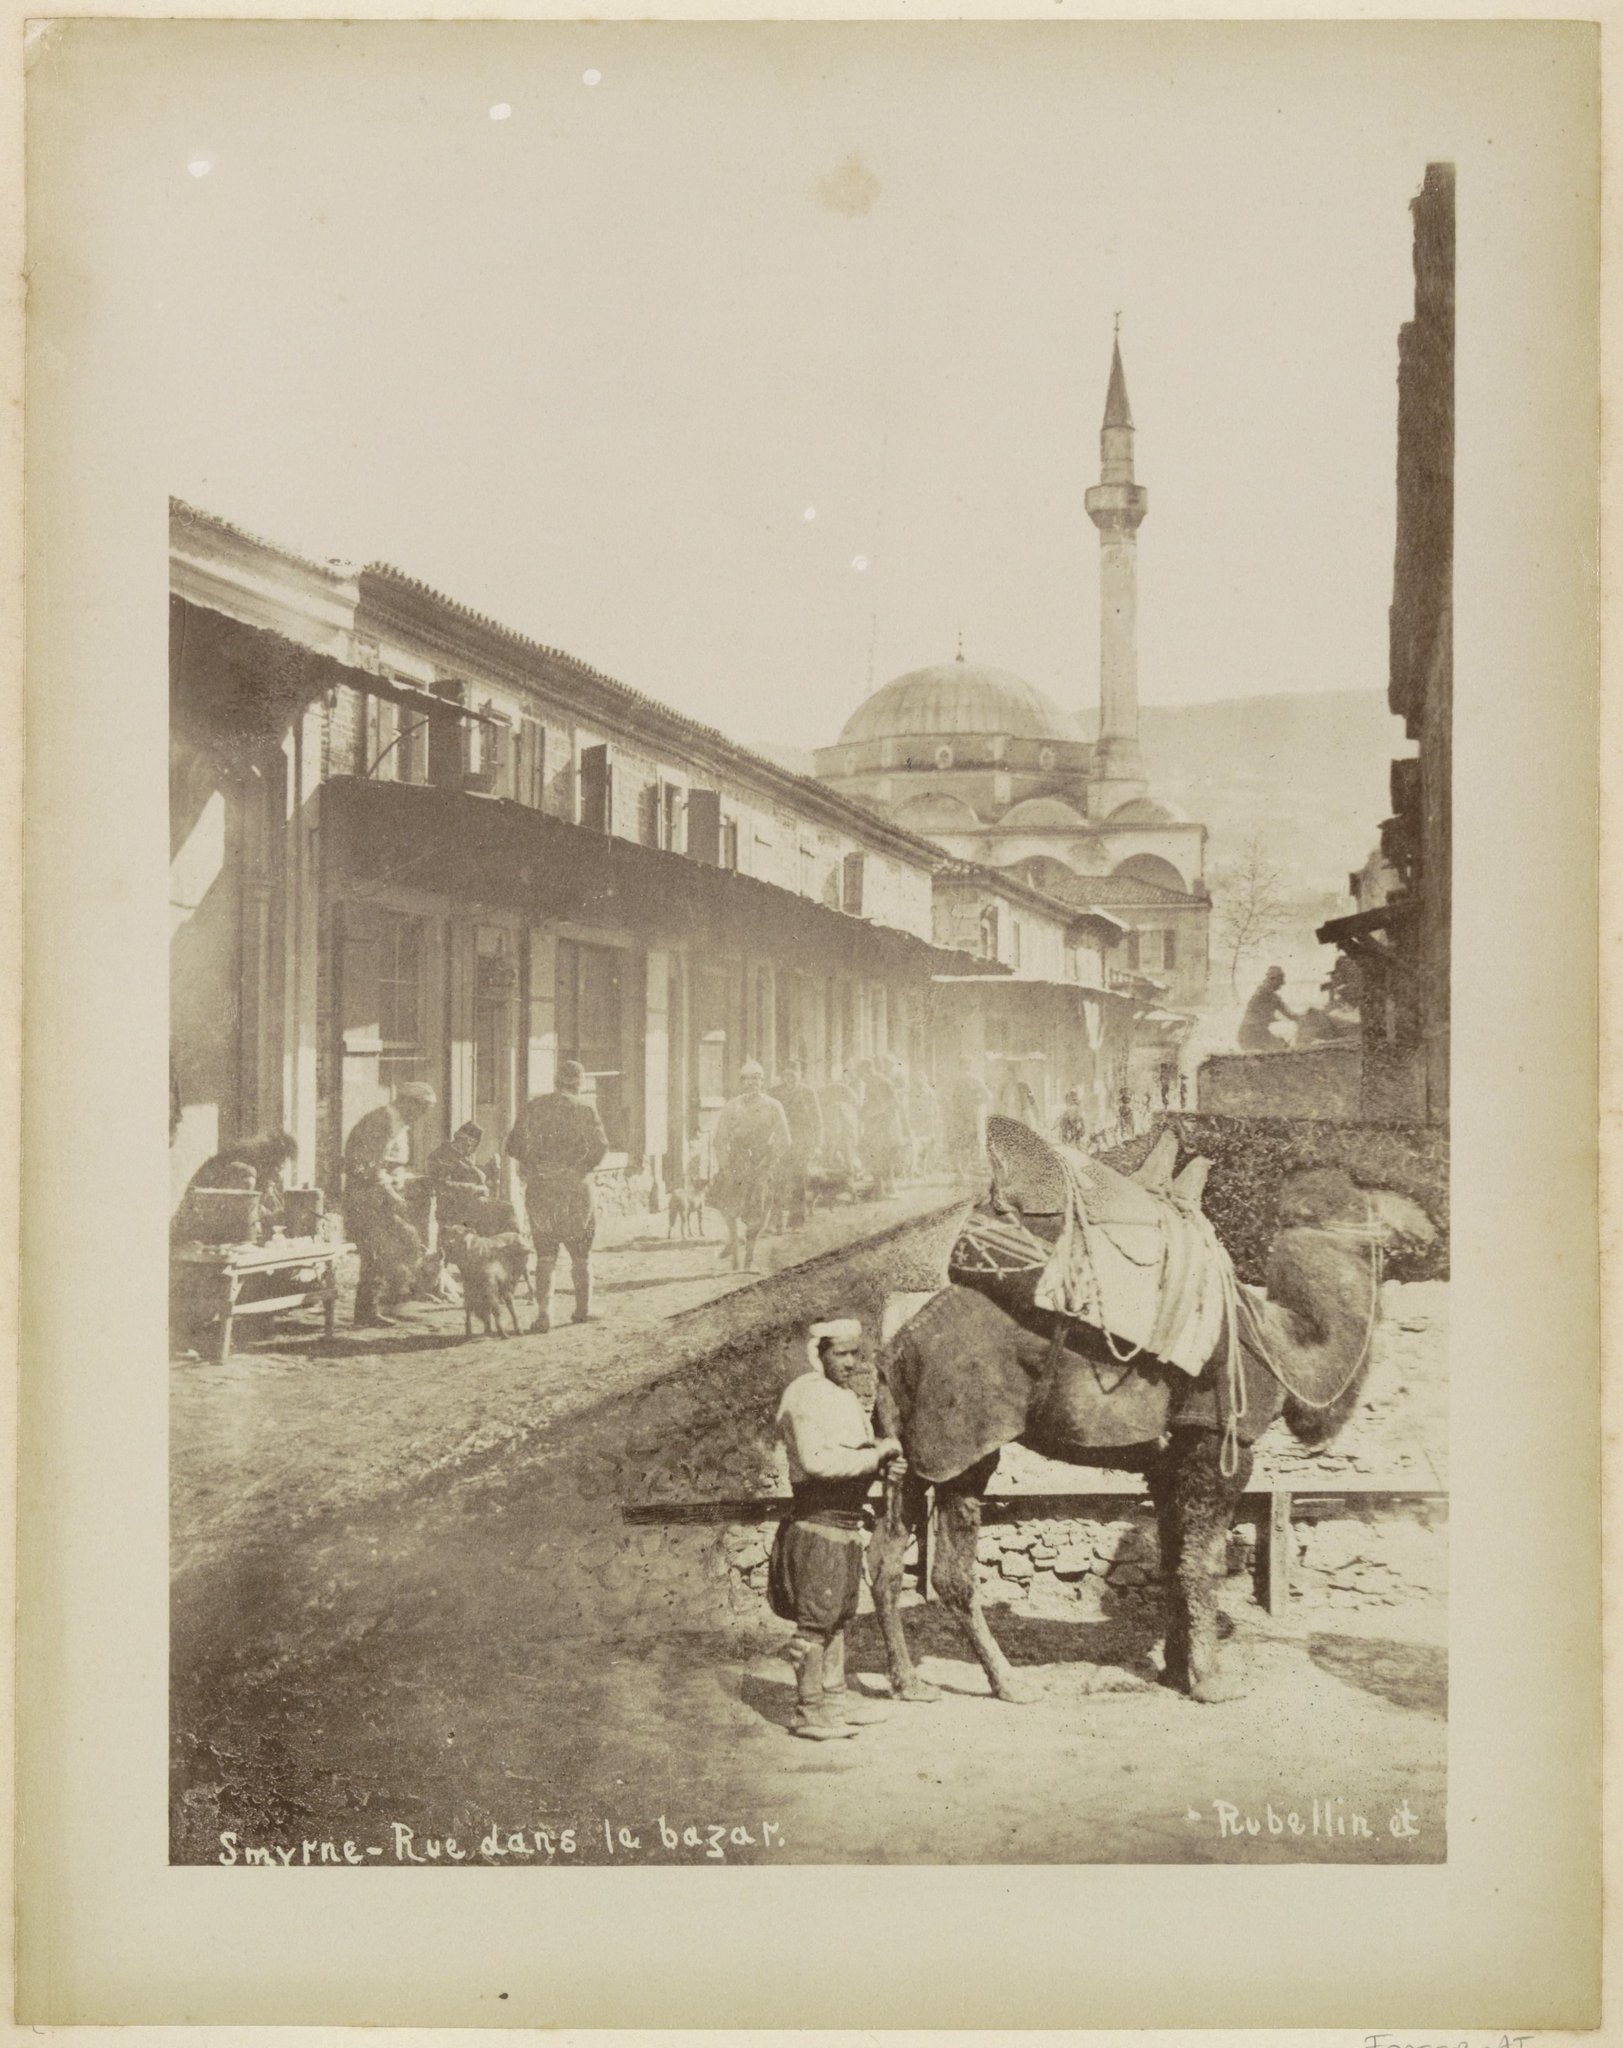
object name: photograph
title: Marktstraat in Smyrna met op de voorgrond een man met een dromedaris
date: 1880-1890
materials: paper, photographic support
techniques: albumen print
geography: smyrna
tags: hoofed animals: dromedary, temple, shrine ~ islam, mohammedanism, street (+ city(-scape) with figures, staffage)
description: Onderdeel van Reisalbum met foto's van bezienswaardigheden in Frankrijk, Griekenland en Turkije.